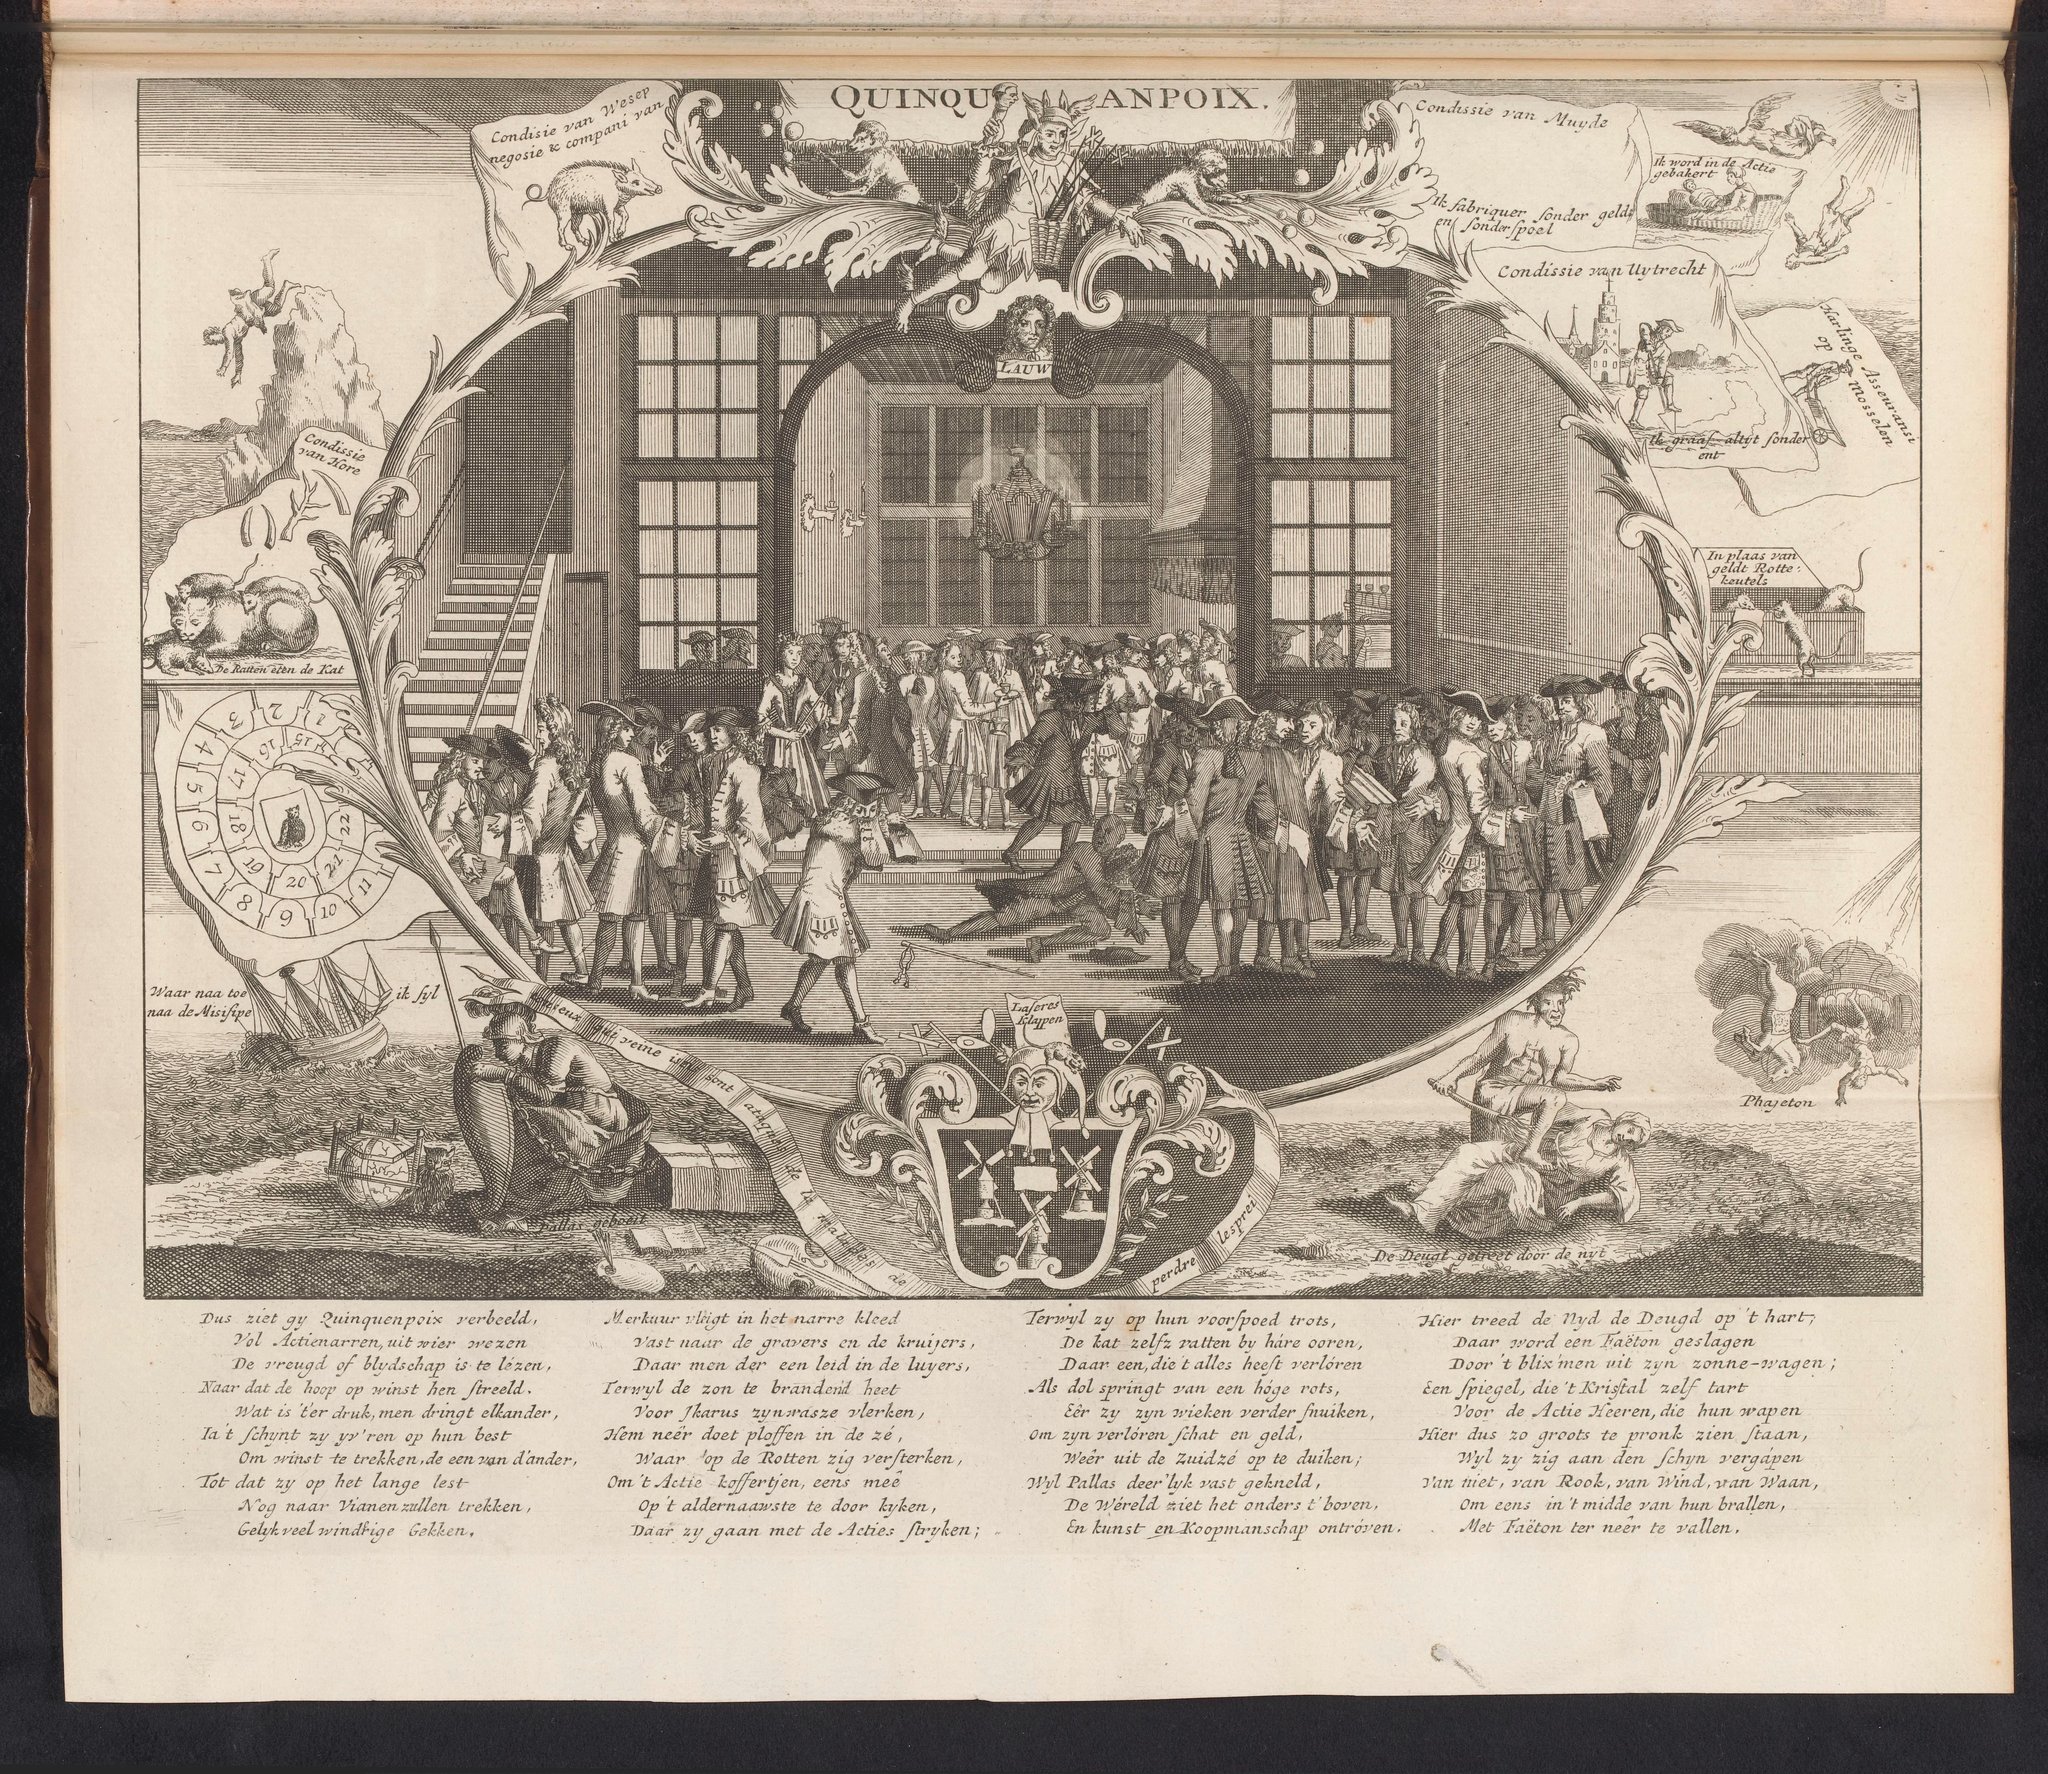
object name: print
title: Het Groote Tafereel der Dwaasheid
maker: Anonymous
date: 1720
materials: paper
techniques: engraving, etching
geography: northern netherlands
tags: financial panic, inn, coffee-house, public house, etc.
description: Centrale voorstelling van het koffiehuis Quincampoix in de Kalverstraat, het centrum van de actiehandel te Amsterdam, 1720. In de omlijsting verwijzingen naar projecten te Muiden, Utrecht, Harlingen, Weesp, Rotterdam en de Mississippi. Onderaan een wapen opgebouwd uit windmolens en een narrenhoofd. In het onderschrift een vers in vier kolommen. Prent in de gebonden eerste uitgave (304 B 11) van Het Groote Tafereel der Dwaasheid met spotprenten op de Windhandel of Actiehandel van 1720.